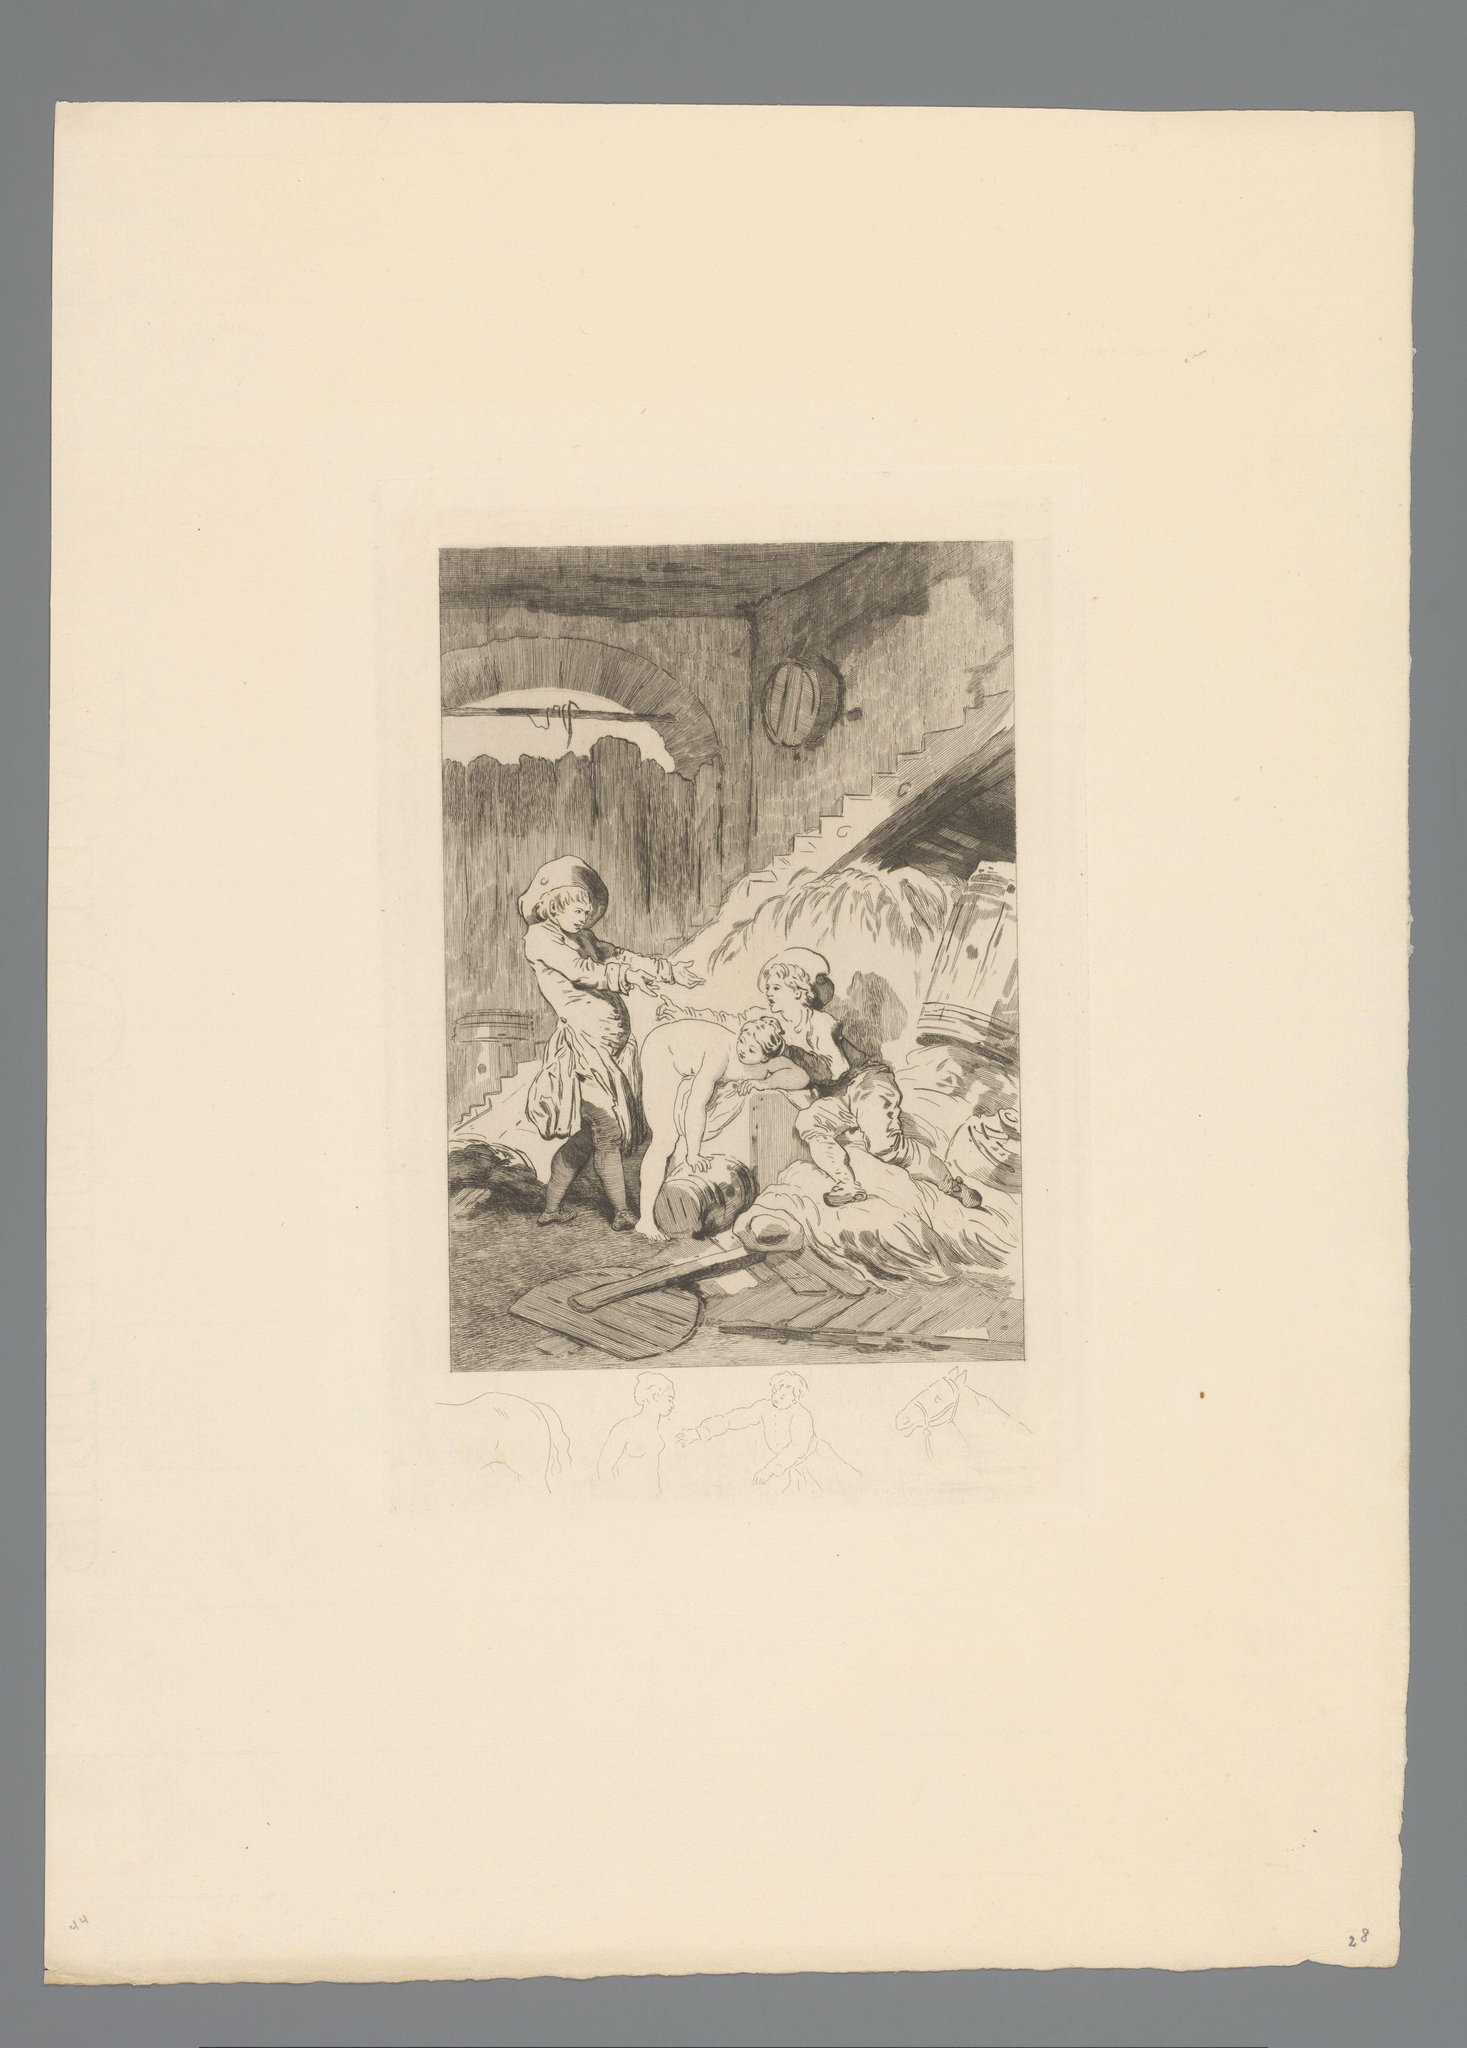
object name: reproduction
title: Figures des Contes de La Fontaine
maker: Anonymous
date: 1880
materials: paper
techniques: photoaquatint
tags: one-sided courting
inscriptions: collector's mark: Lugt 2228, collector's mark:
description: Martial Potémont maakte etsen naar de tekeningen van Fragonard, die zich bevonden in een manuscript in de collectie van de verzamelaar Eugène Paillet. Rouquette bood hem aan de tekeningen zo exact mogelijk in prent te laten brengen door Martial Potémont: dit resulteerde in een serie van 57 etsen. Vervolgens werden deze gereproduceerd door middel van heliogravure. Deze omslag betreft een editie voor de letter, "Eau forte pure", de 1e staat van 3 waar men uit kon kiezen bij deze serie.